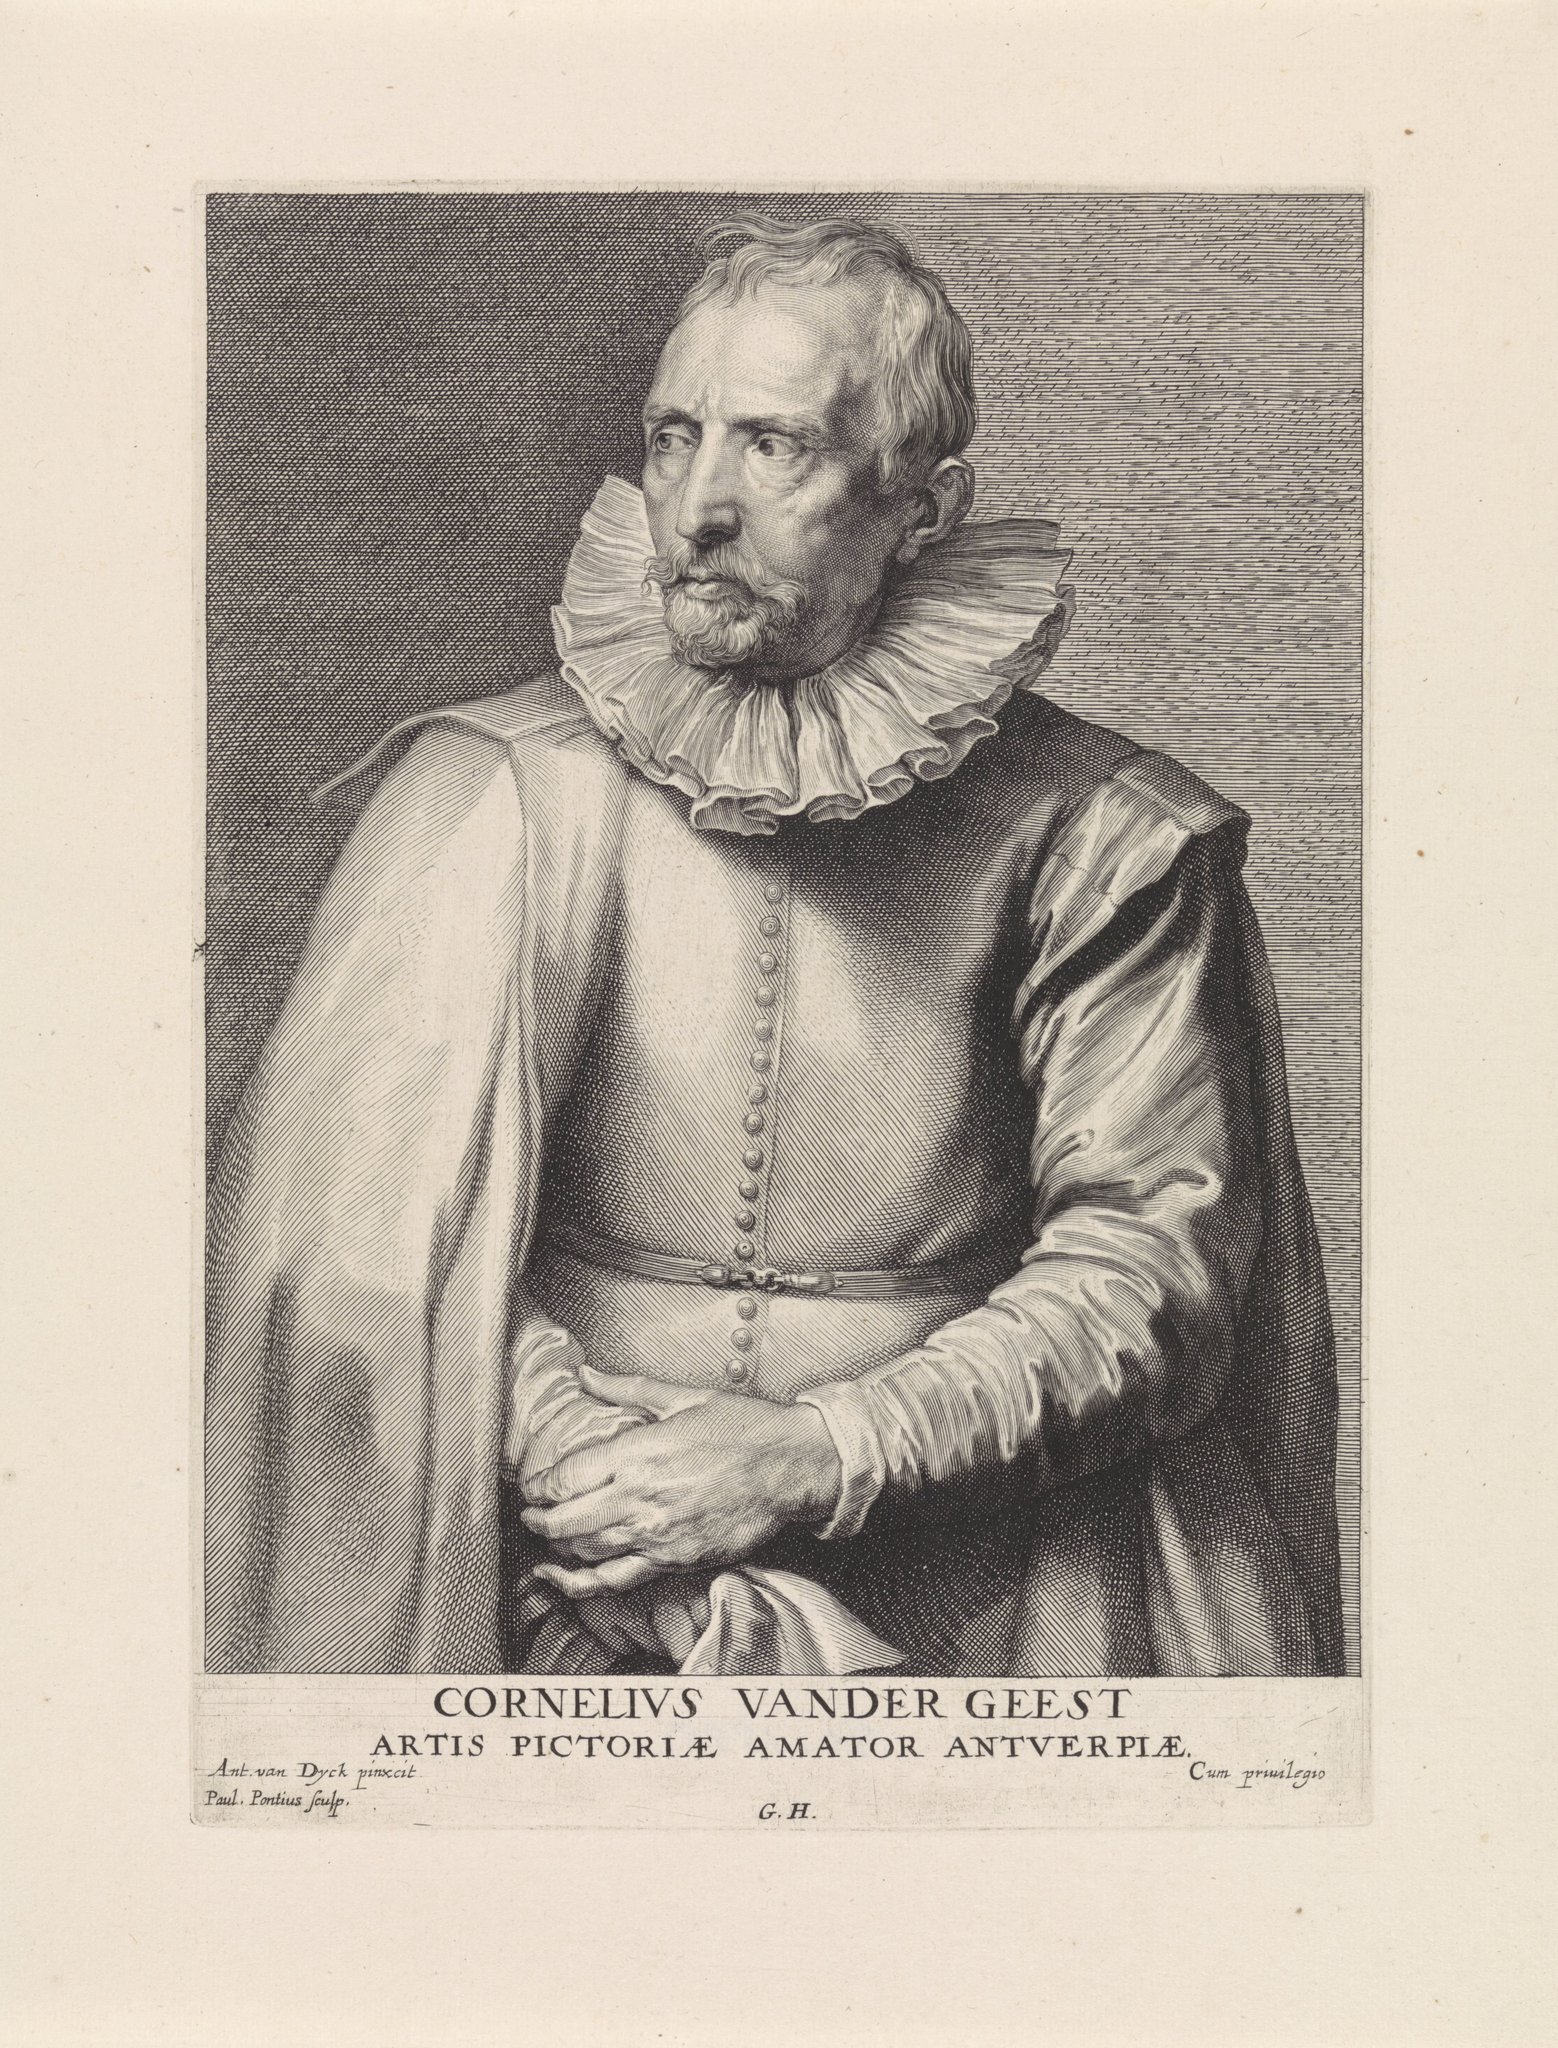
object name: print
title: Portret van Cornelis van der Geest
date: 1616-1657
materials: paper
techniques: engraving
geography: antwerp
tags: cornelis van der geest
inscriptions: collector's mark: Lugt 2166, collector's mark: Lugt 2760, collector's mark: Lugt 2228